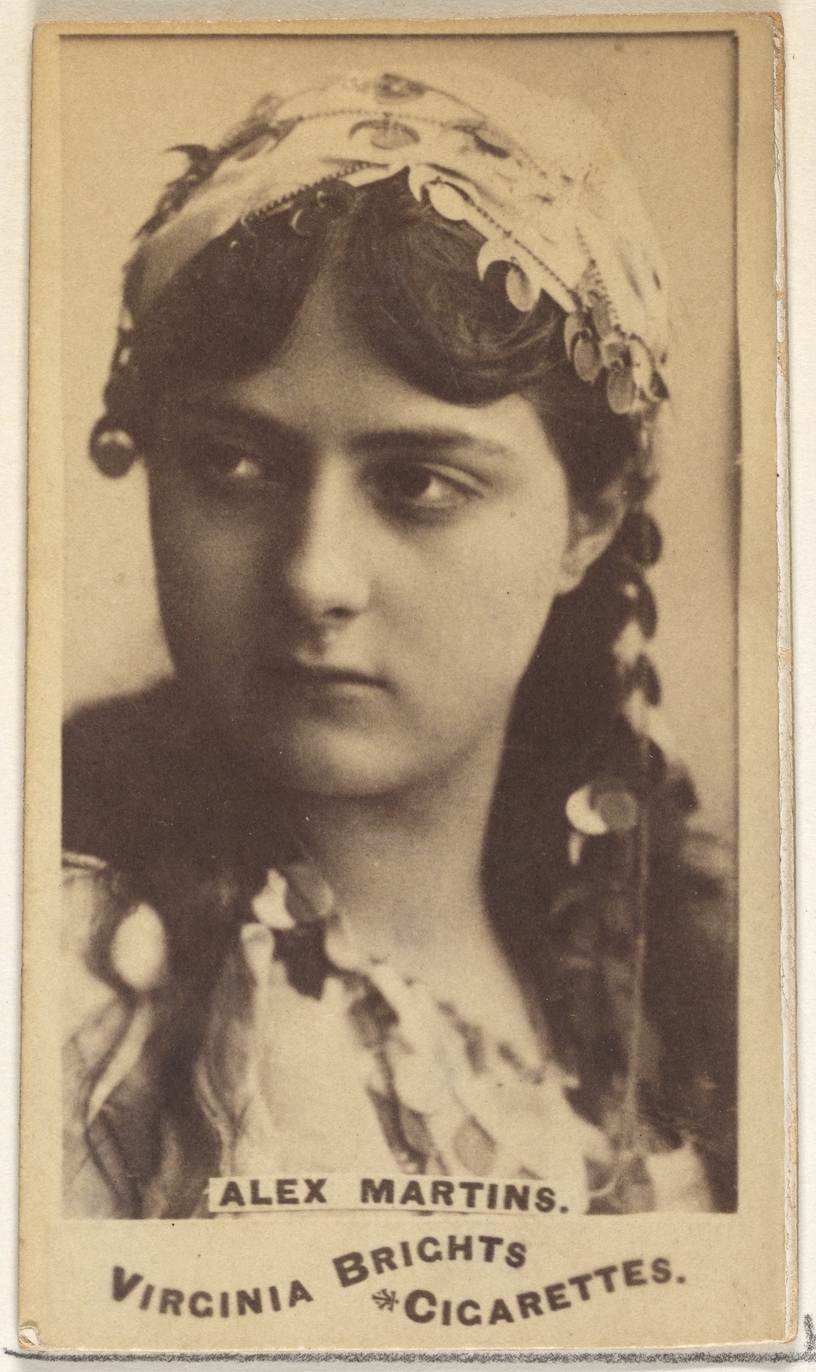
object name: photograph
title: Alex Martins, from the Actors and Actresses series (N45, Type 1) for Virginia Brights Cigarettes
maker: allen & ginter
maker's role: publisher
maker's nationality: american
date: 1888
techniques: albumen silver print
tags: portraits,women,actresses